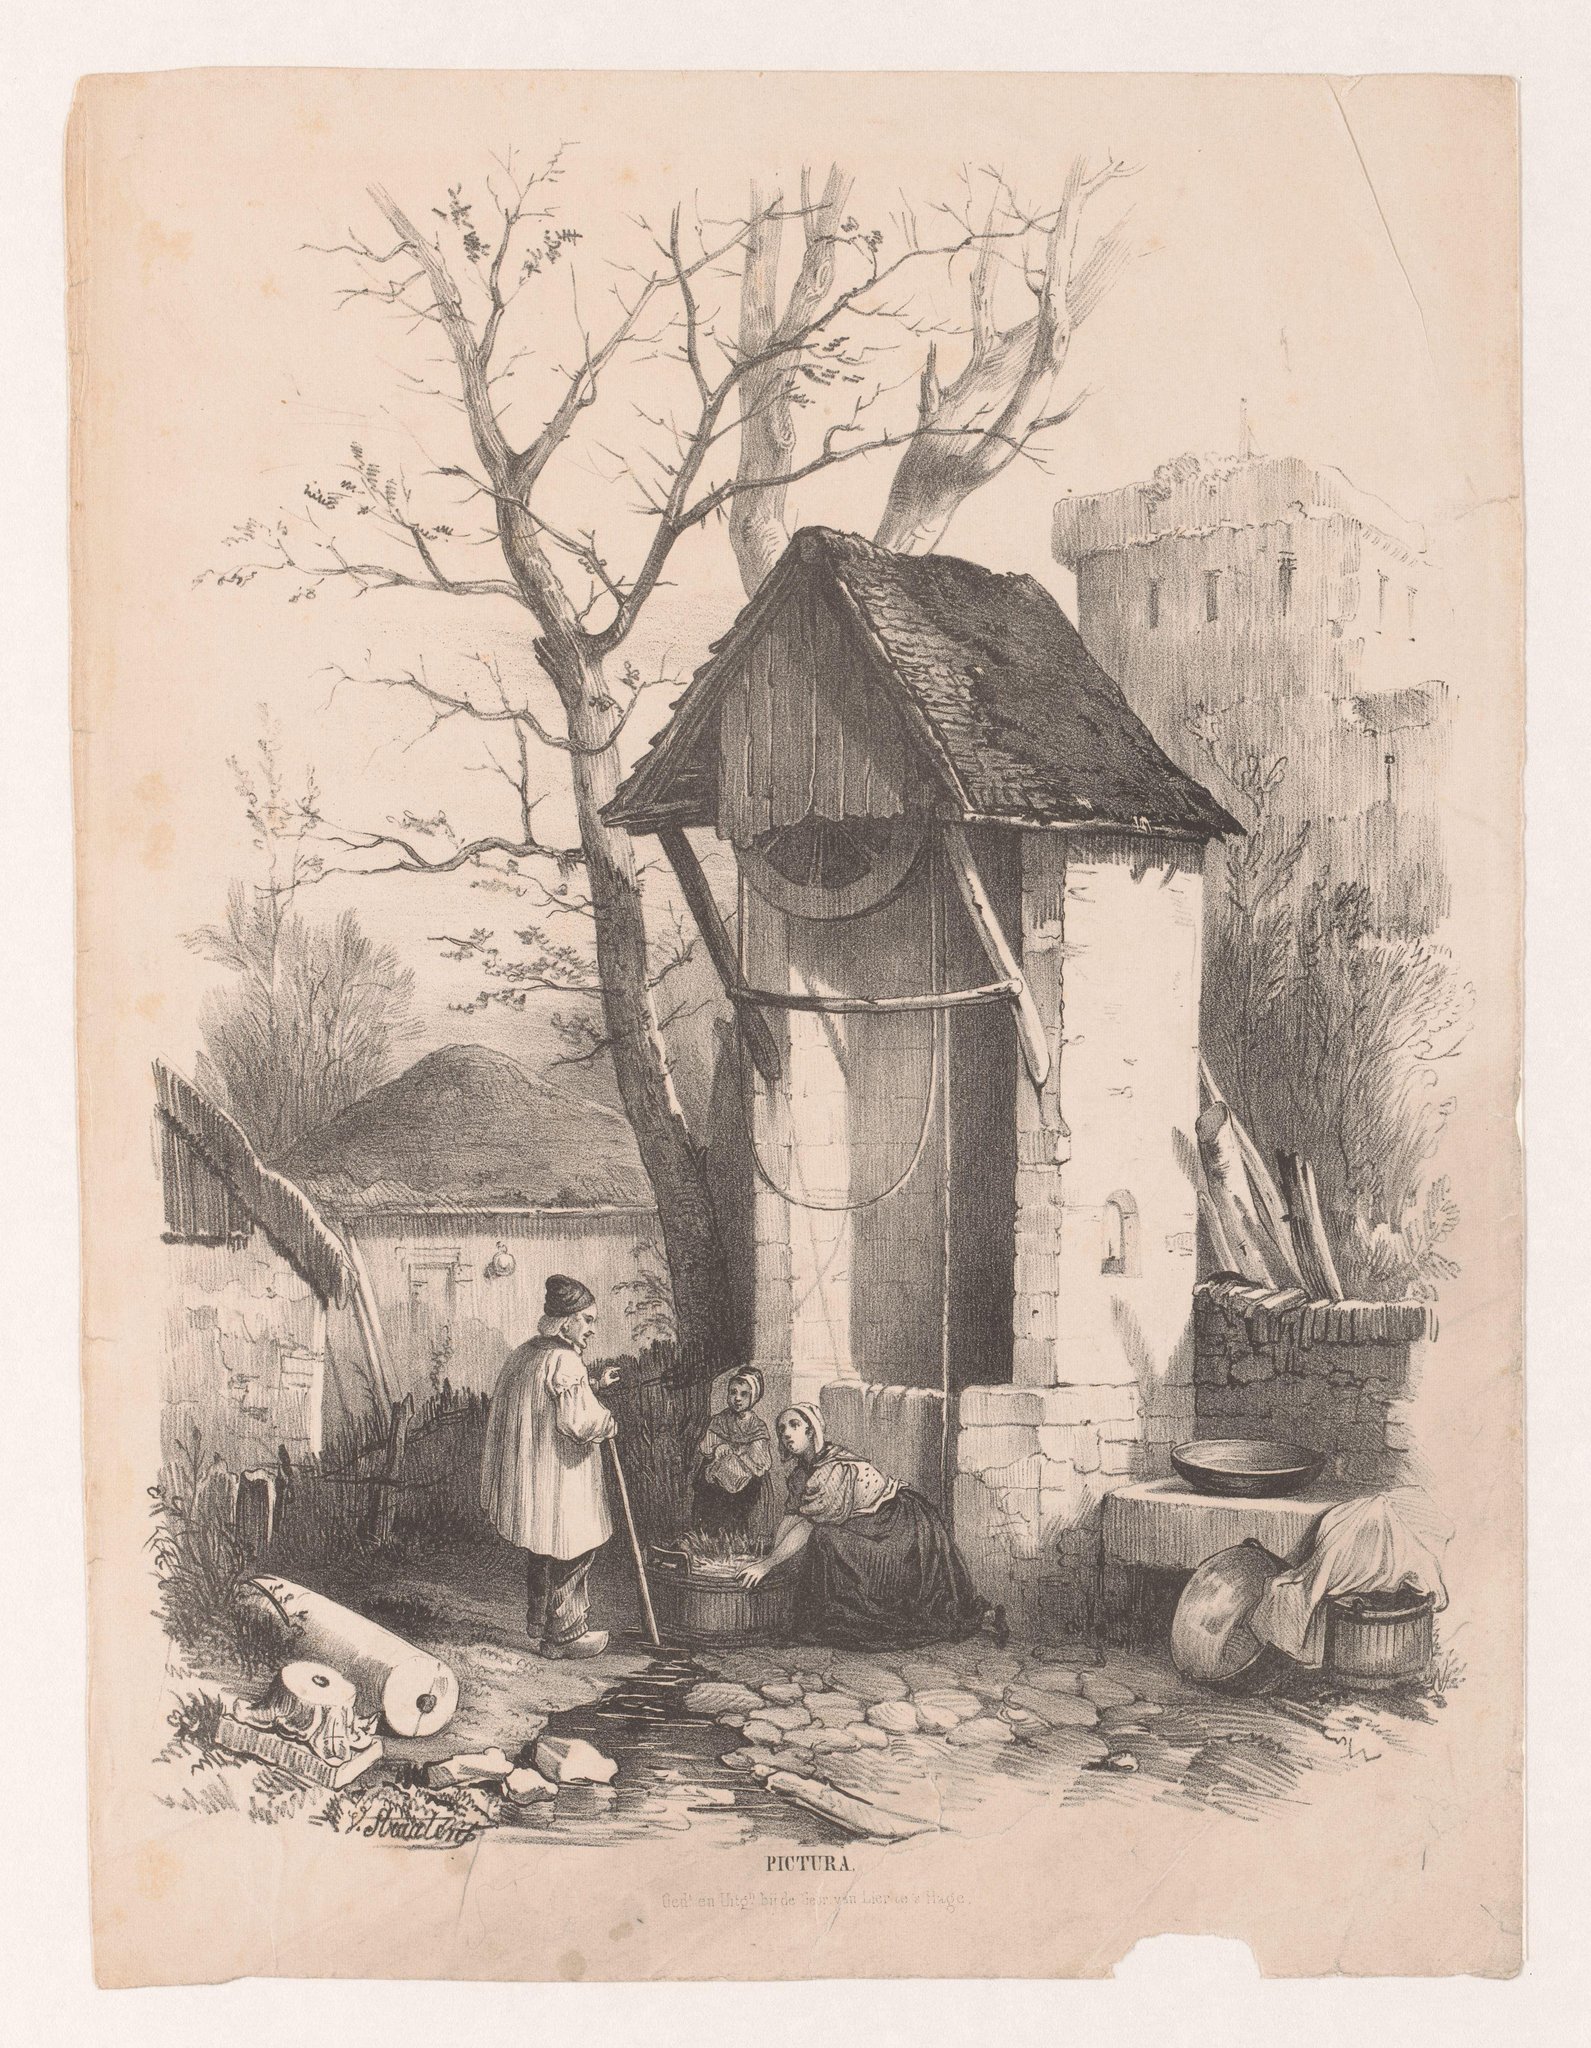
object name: print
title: Pictura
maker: marinus adrianus van straten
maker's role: print maker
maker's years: 1808-1863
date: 1833-1850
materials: paper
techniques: lithograph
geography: the hague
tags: well, conversation, dialogue; conversation piece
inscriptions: collector's mark: Lugt 2228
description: Een boer met stok is in gesprek met een vrouw en kind met een mand voor een waterput.